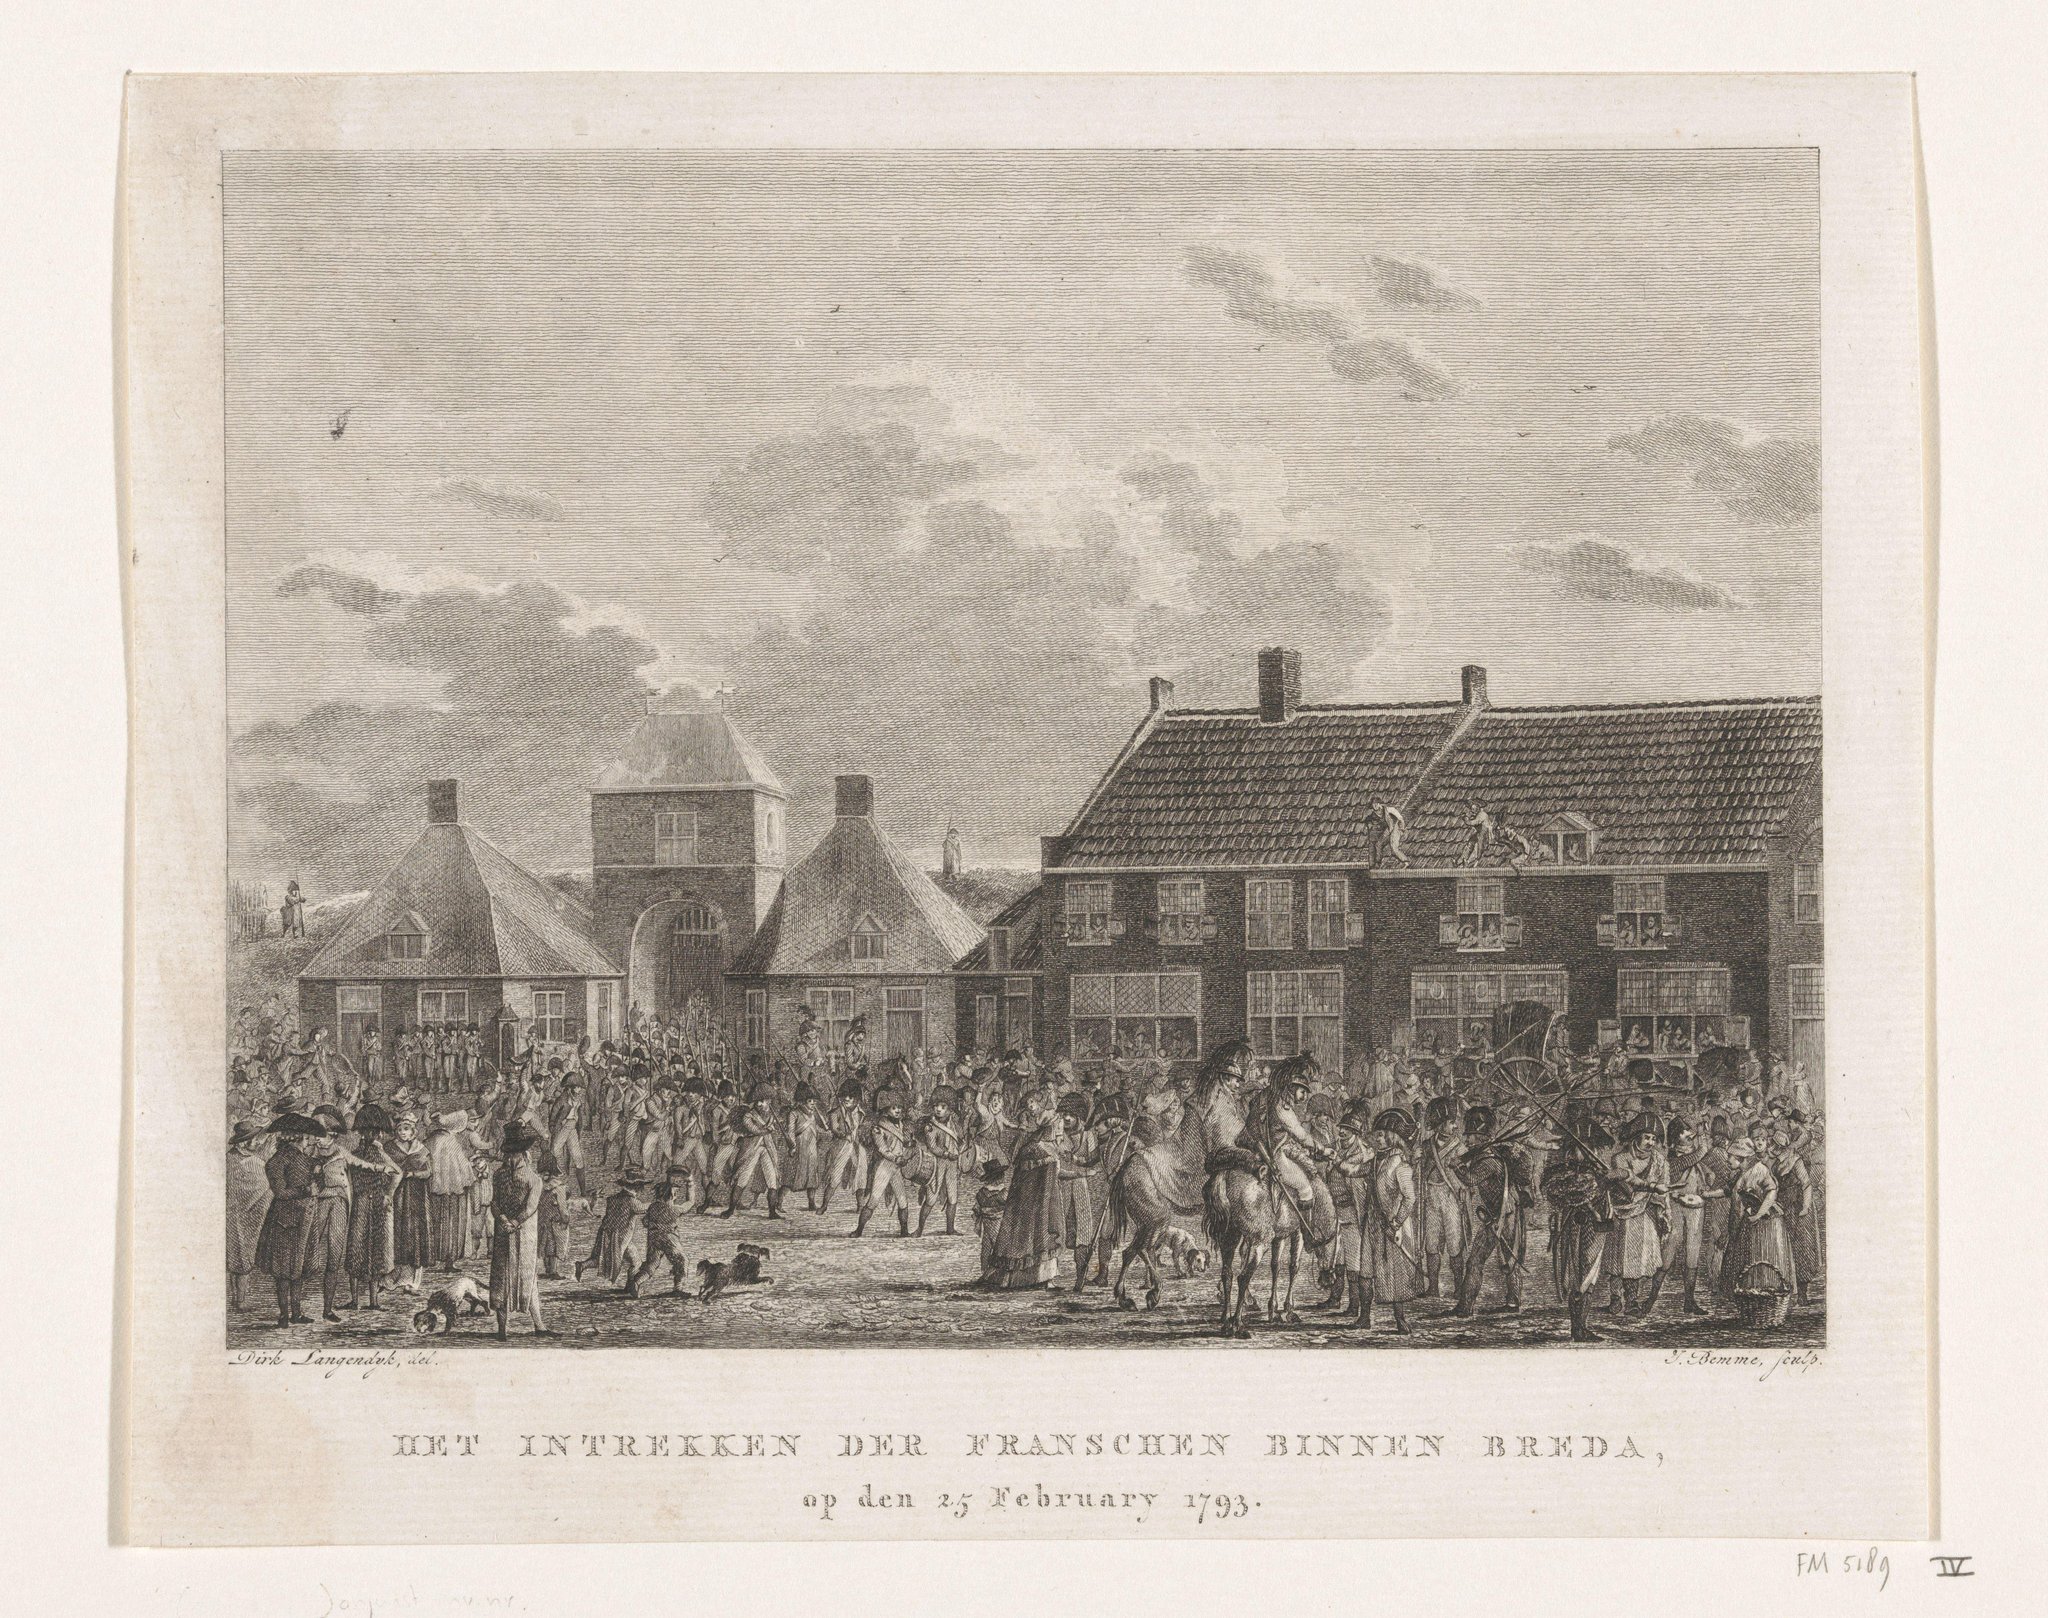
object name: print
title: Het intrekken der Franschen binnen Breda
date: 1800-1841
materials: paper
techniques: etching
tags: occupation ~ war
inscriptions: collector's mark: Lugt 2228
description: Franse troepen trekken door de Haagpoort de stad binnen. Op een plein worden ze door de bevolking ontvangen. Rechts bieden vrouwen de soldaten iets te eten aan.